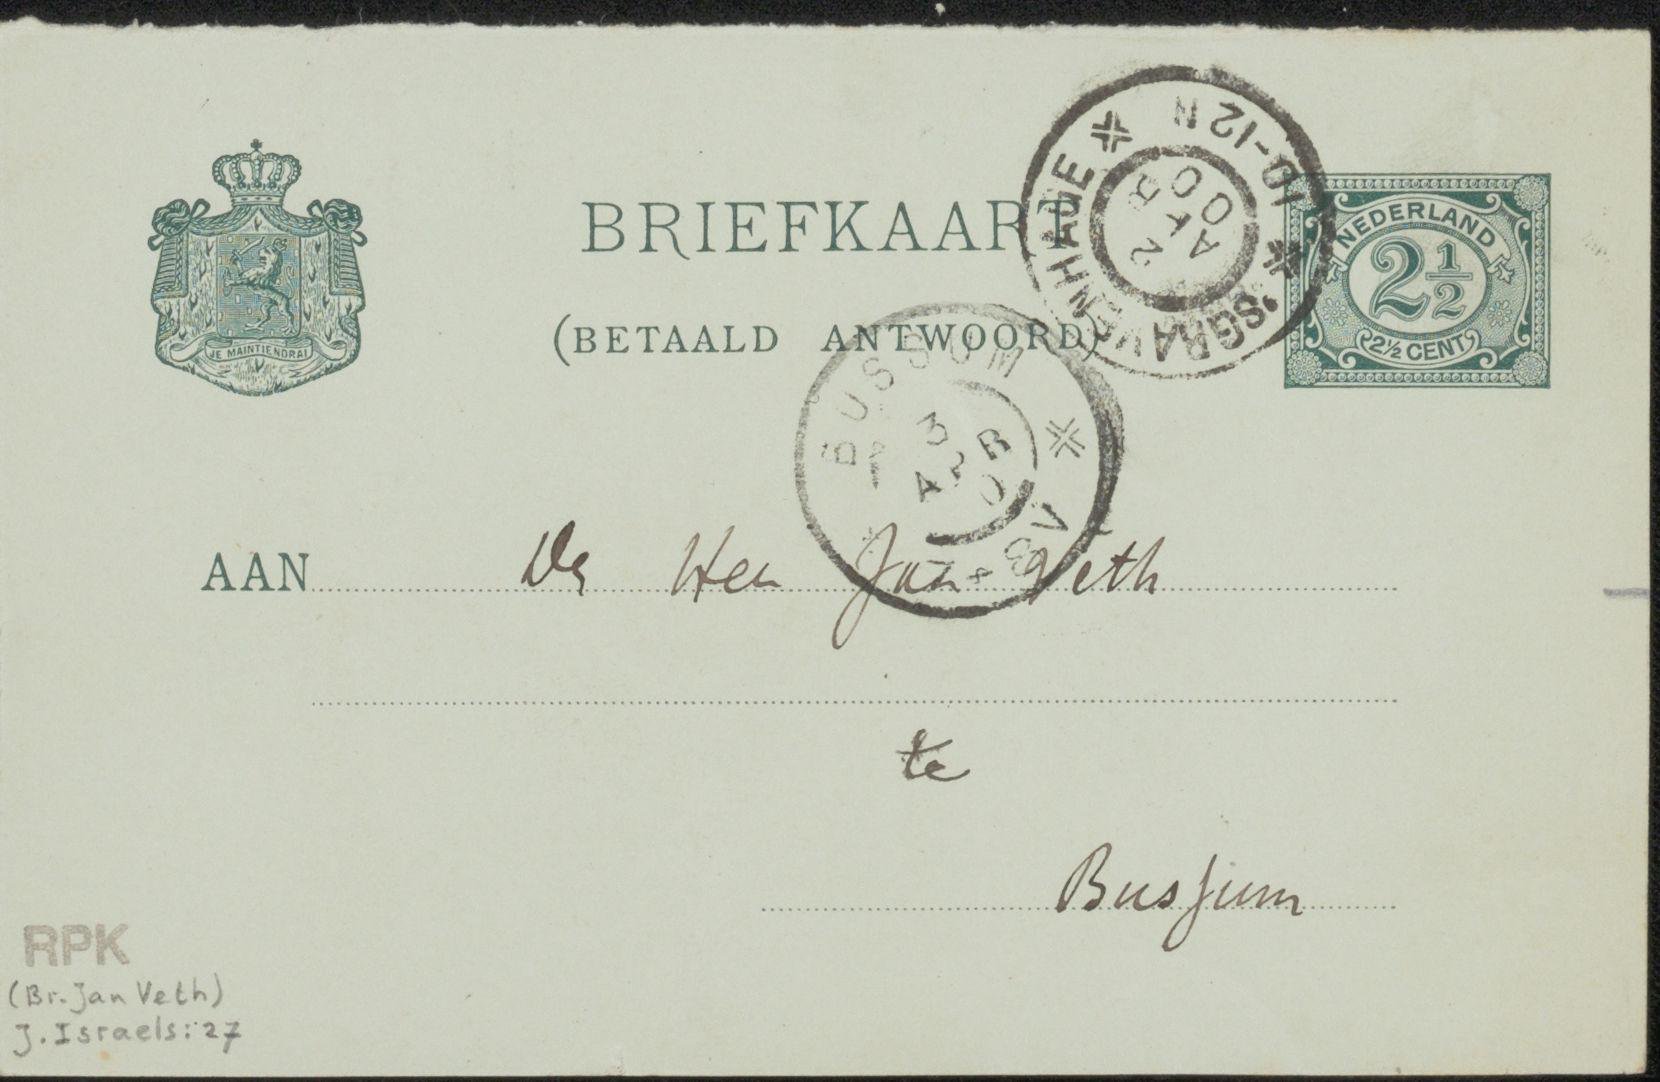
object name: postcard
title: Briefkaart aan Jan Veth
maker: jozef israëls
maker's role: draughtsman, painter, print maker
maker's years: 1824-1911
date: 1900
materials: cardboard, ink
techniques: pen, writing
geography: the hague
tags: dordrecht, amsterdam, designer, jan veth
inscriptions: collector's mark: ‘RPK’